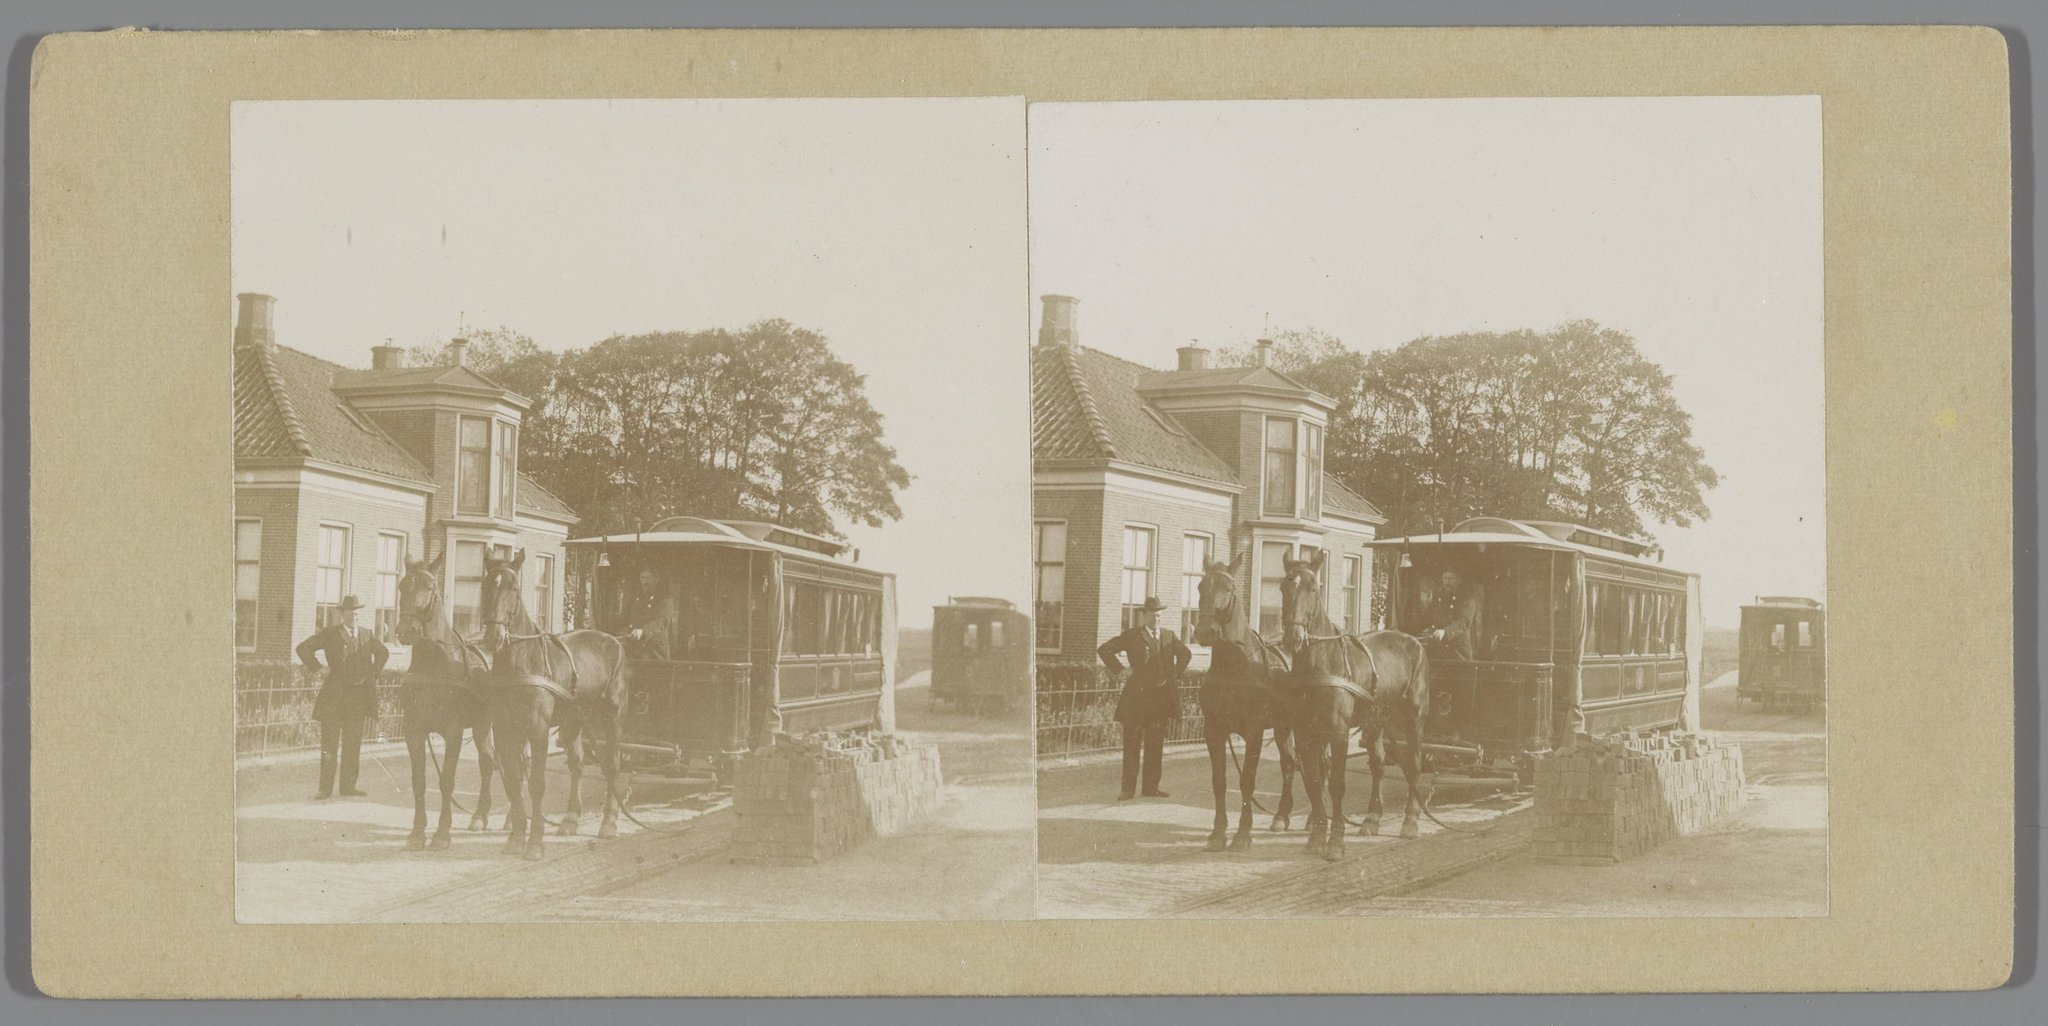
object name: stereograph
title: Paardentram van de lijn Winsum-Ulrum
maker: Anonymous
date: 1907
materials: paper, cardboard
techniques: collodion silver print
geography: groningen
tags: diligence, omnibus, horse-tram